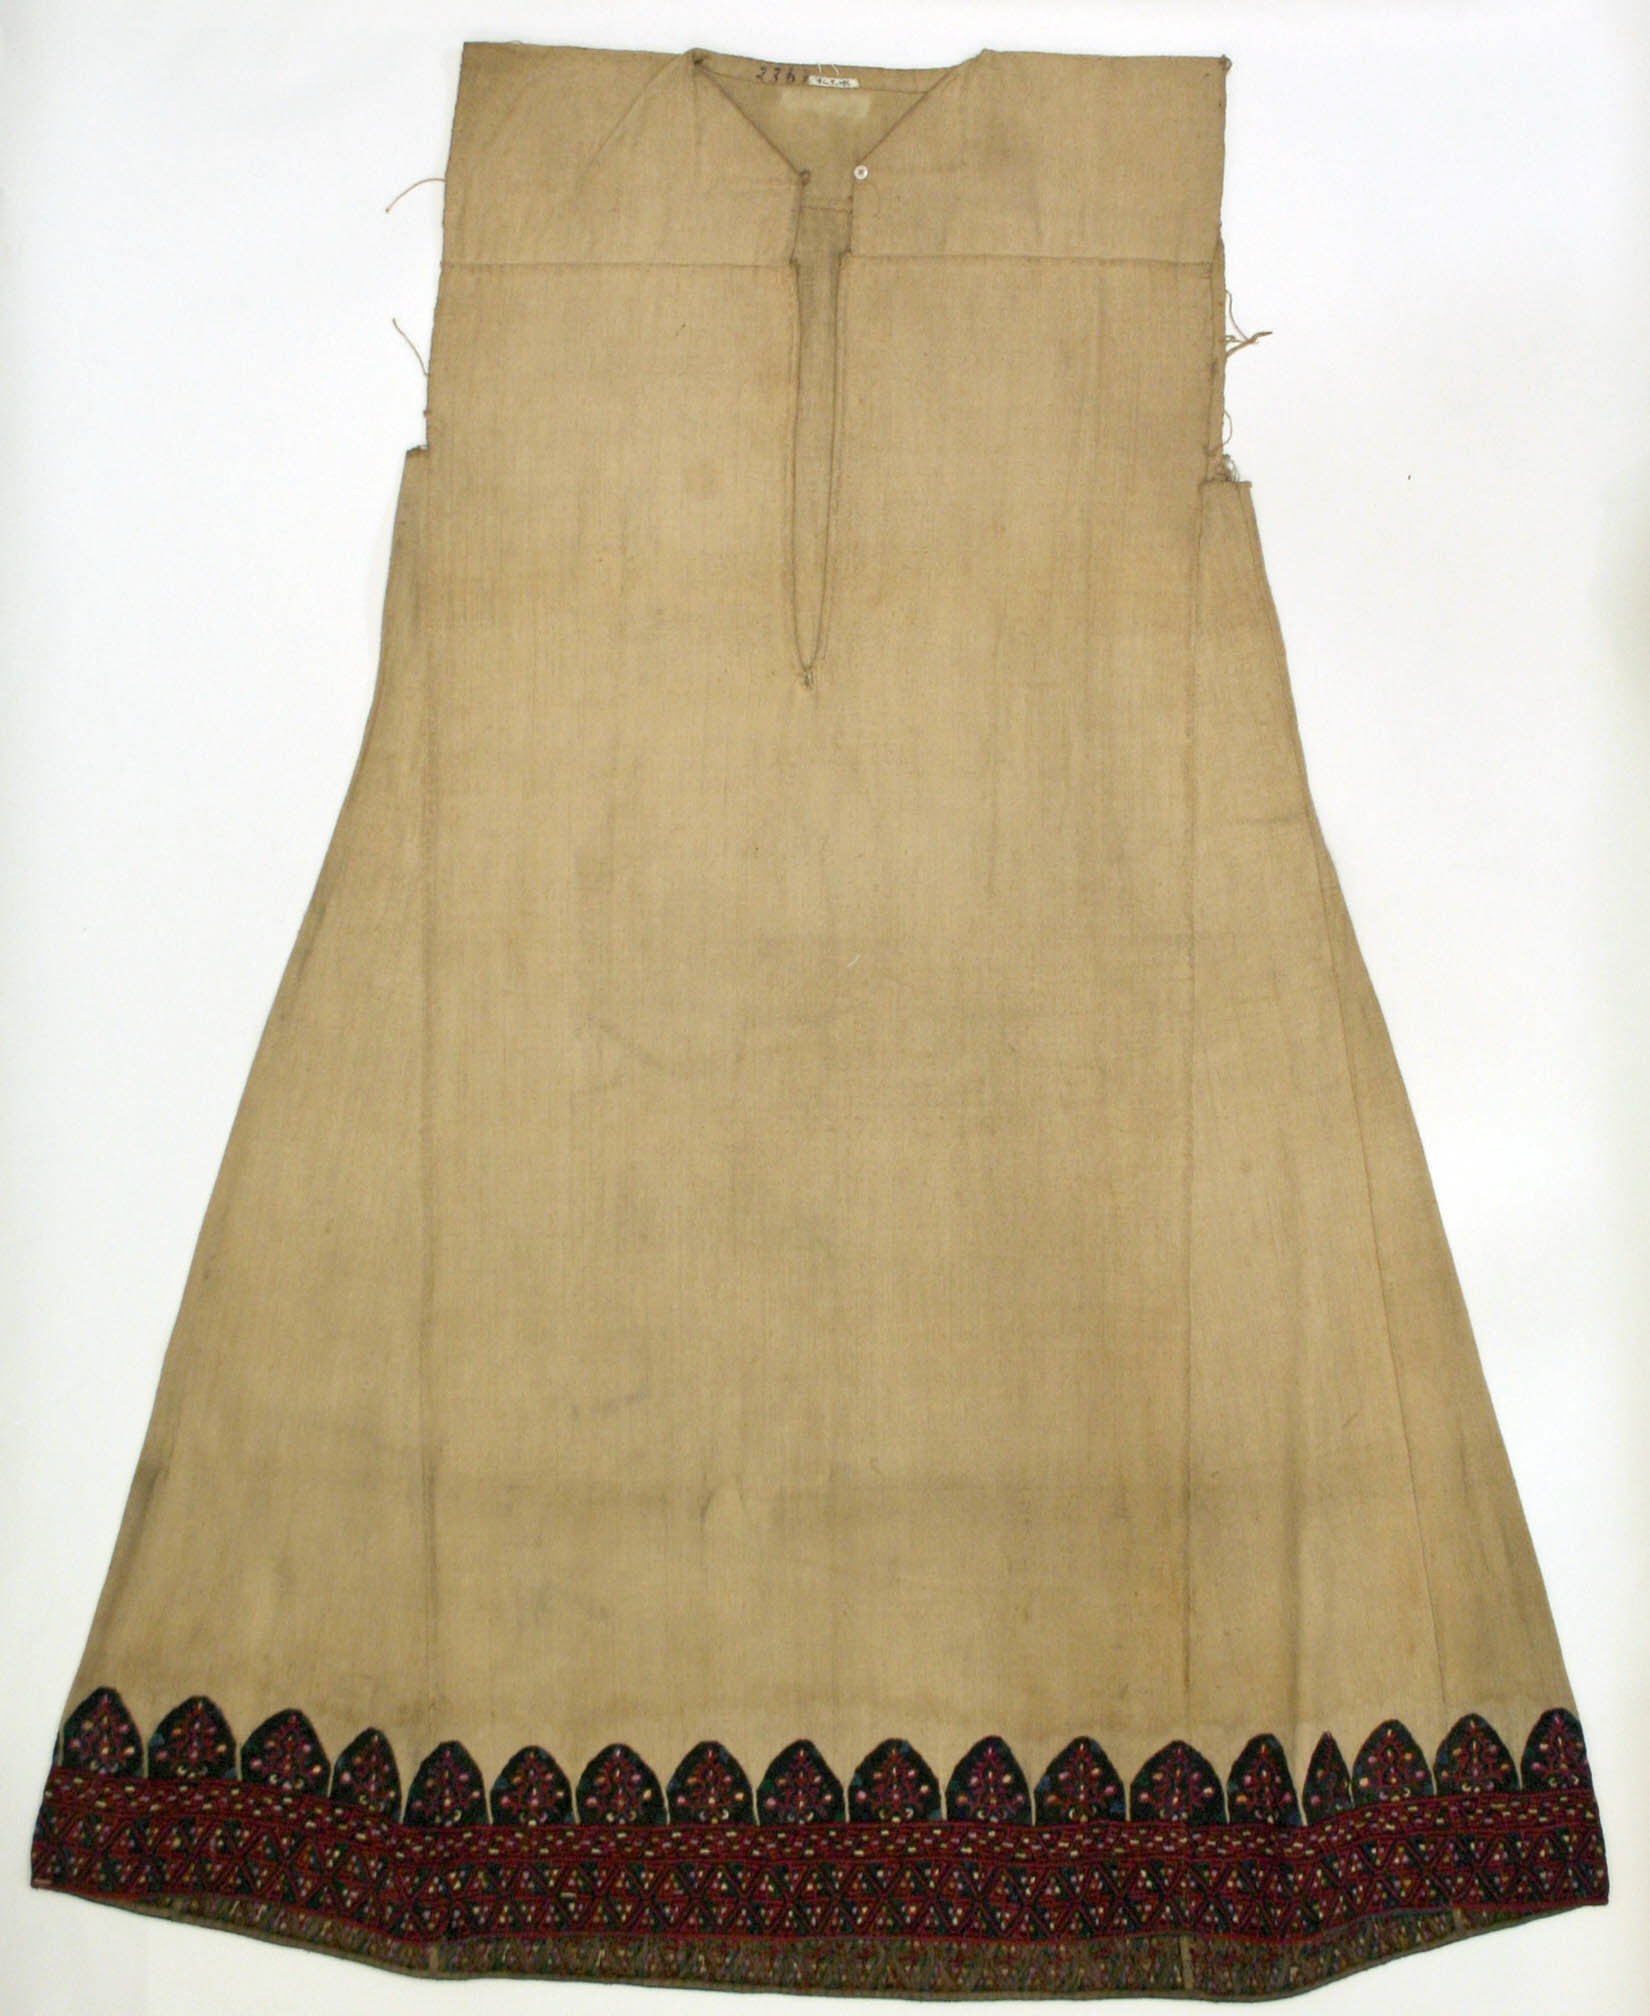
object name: dress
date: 1867-1933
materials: cotton, silk